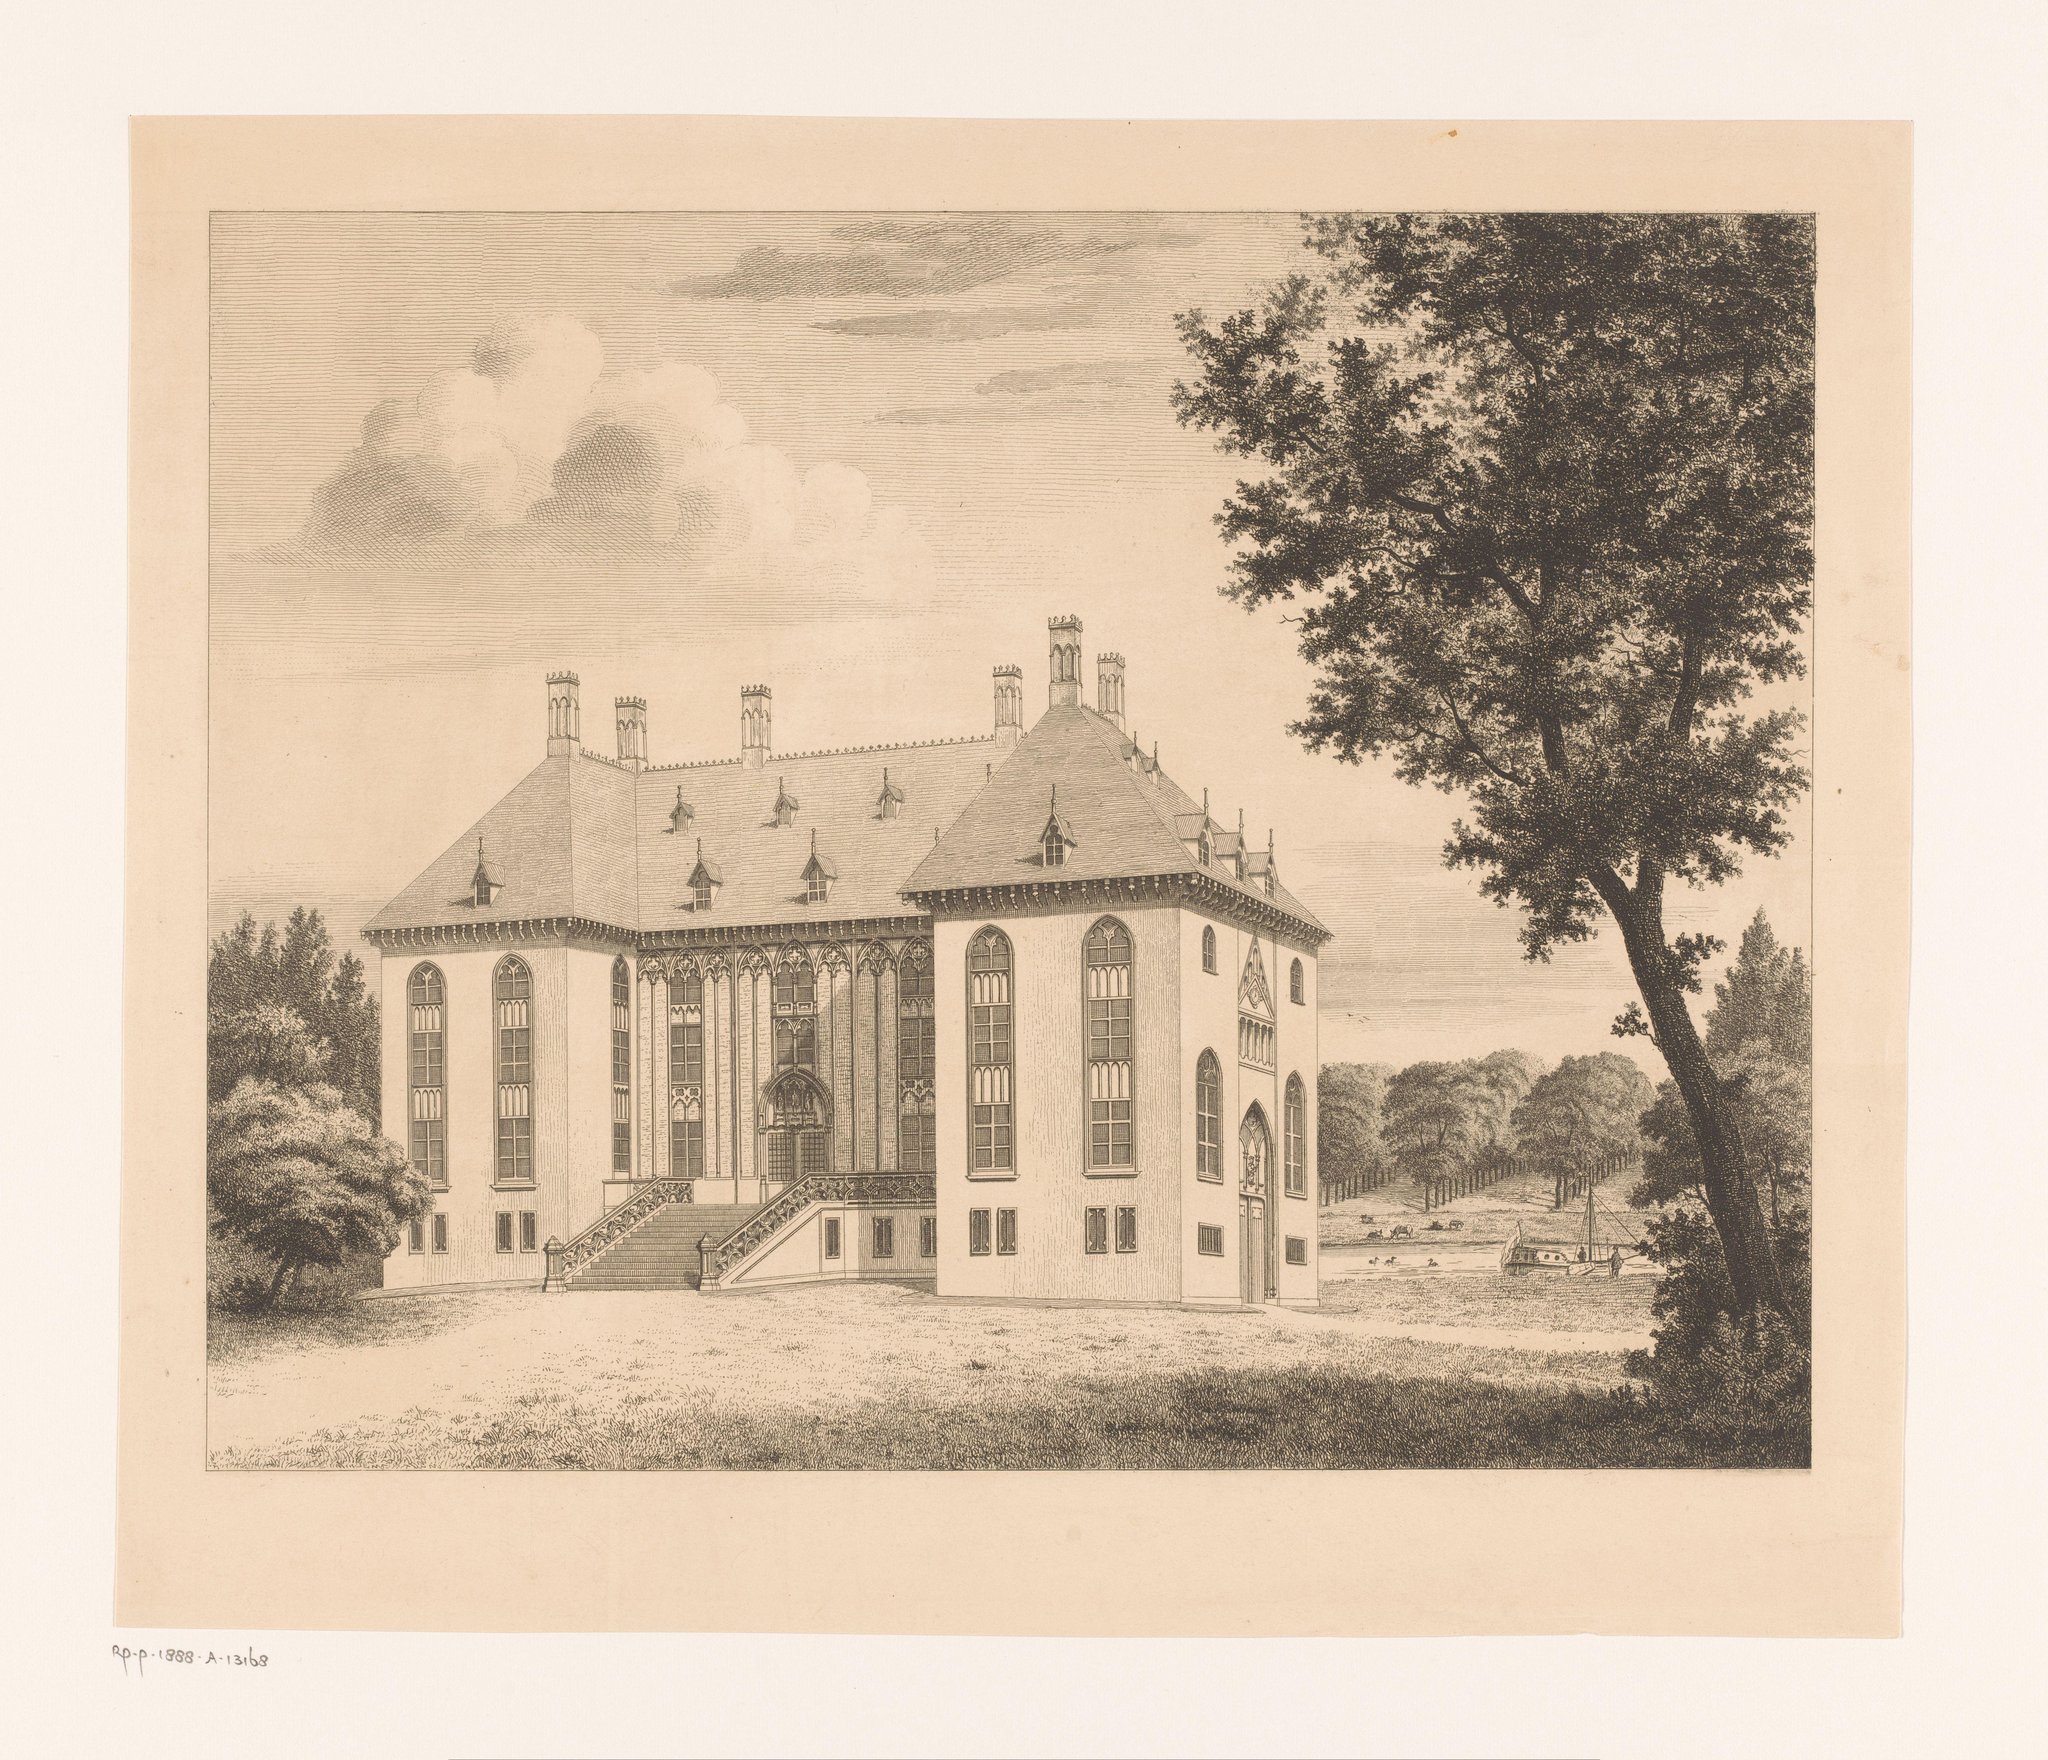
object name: print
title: Kasteel Puttenberg in Beert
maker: jean théodore joseph linnig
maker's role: draughtsman, print maker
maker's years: 1815-1891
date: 1853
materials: paper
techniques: drypoint, etching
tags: castle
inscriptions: collector's mark: Lugt 2228